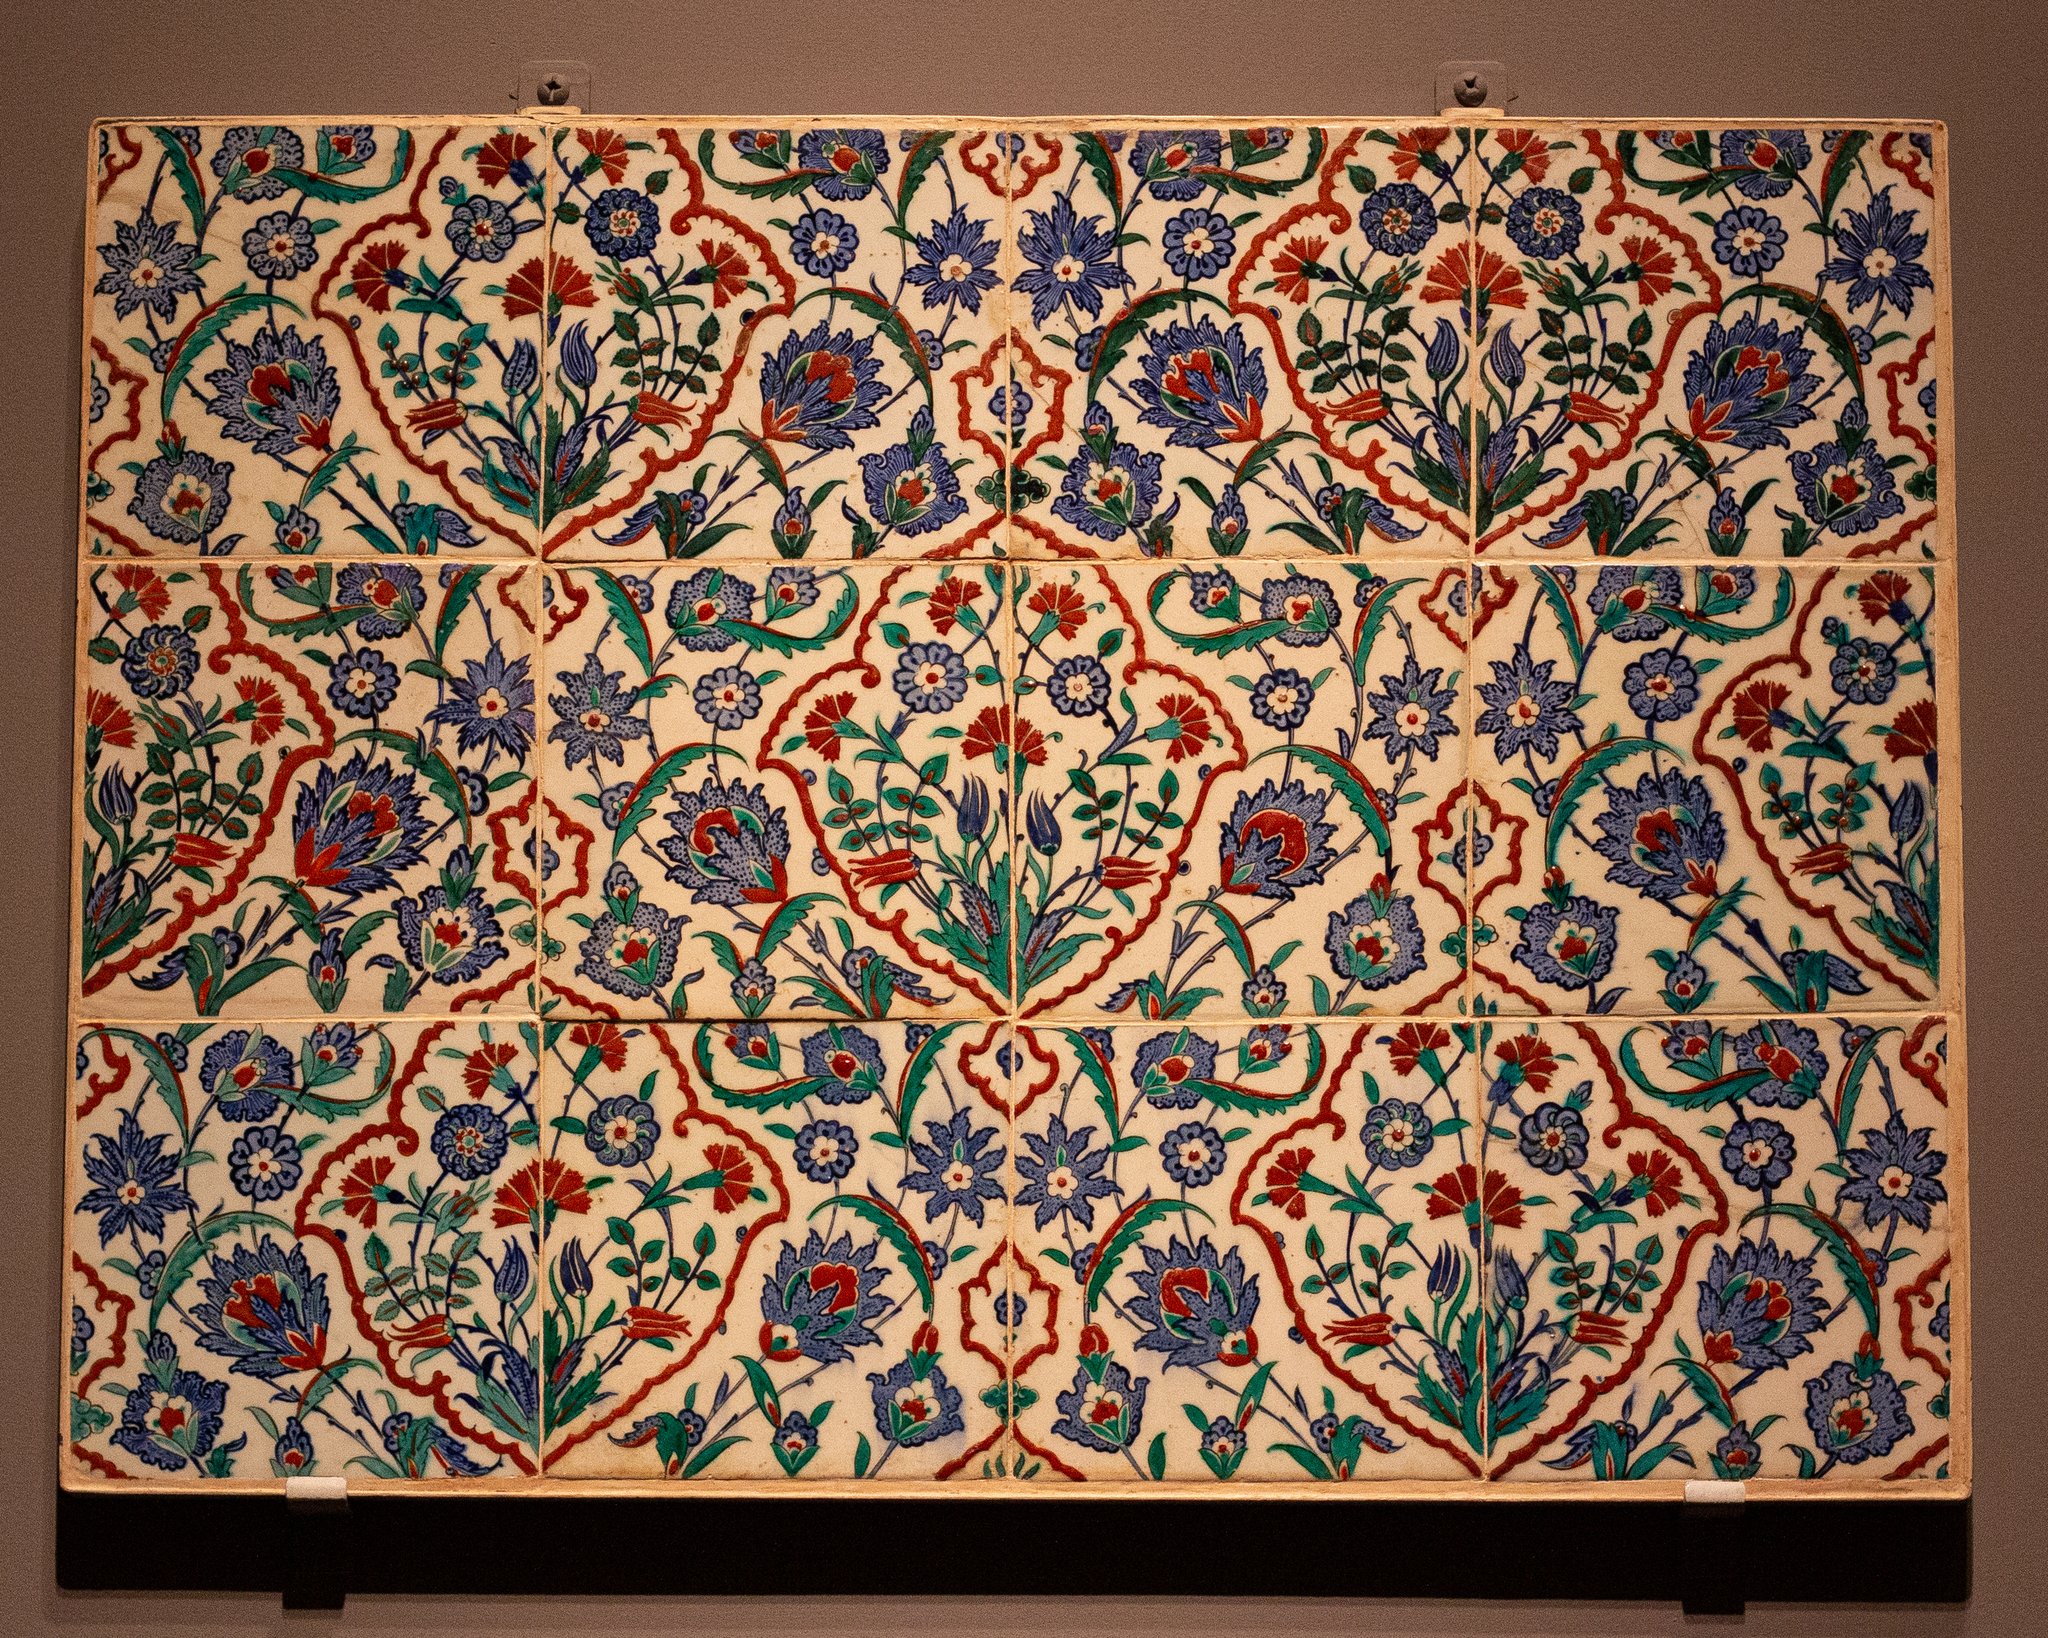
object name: tile panel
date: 1601-1633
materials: stonepaste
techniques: painting, polychrome, underglaze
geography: turkey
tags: flowers